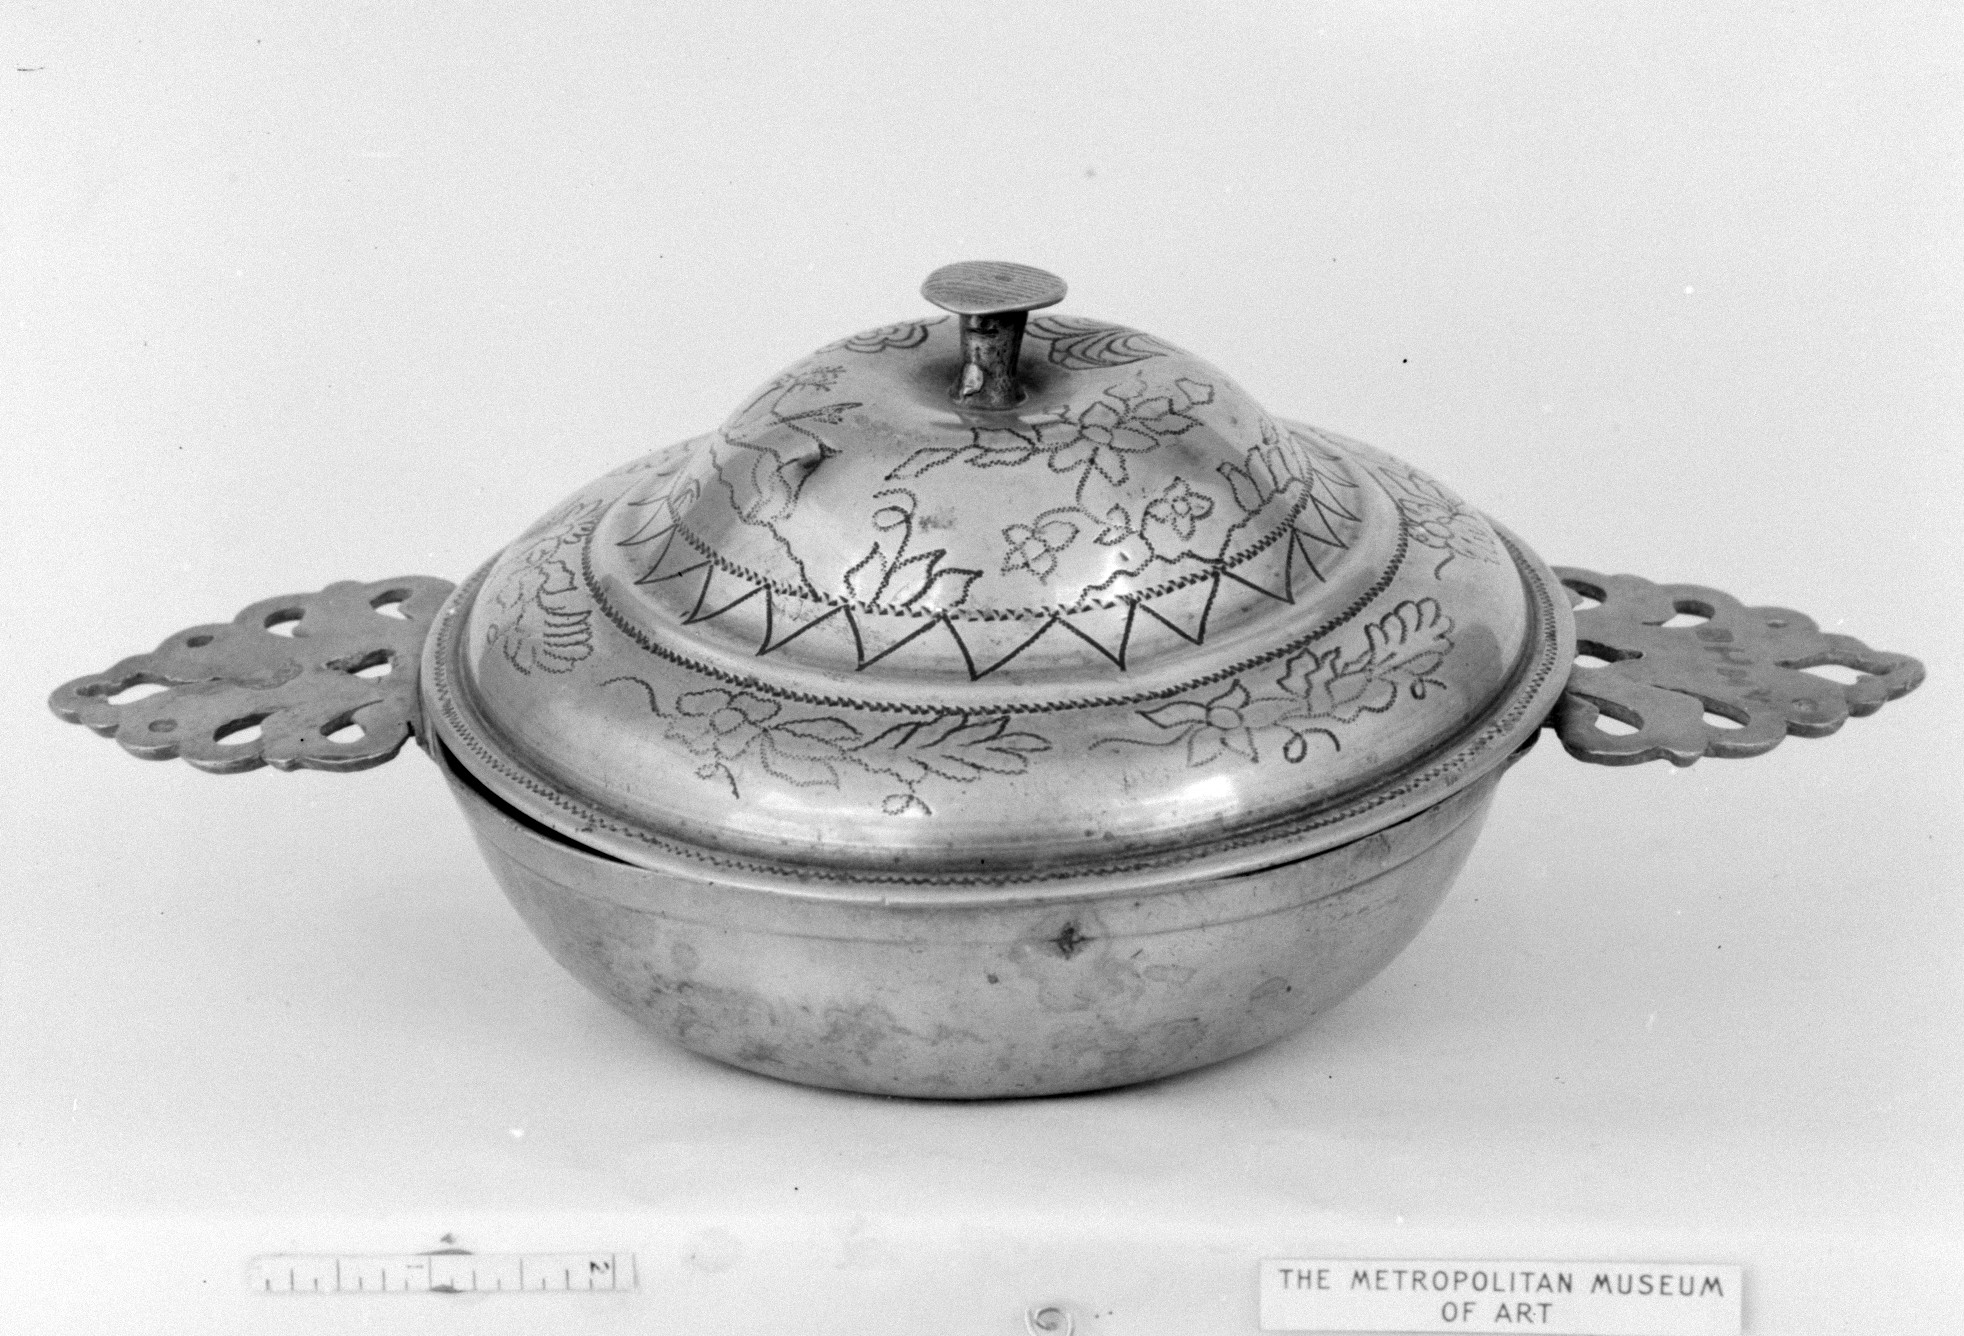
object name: écuelle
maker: p. g. l.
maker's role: maker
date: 1667-1733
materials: pewter